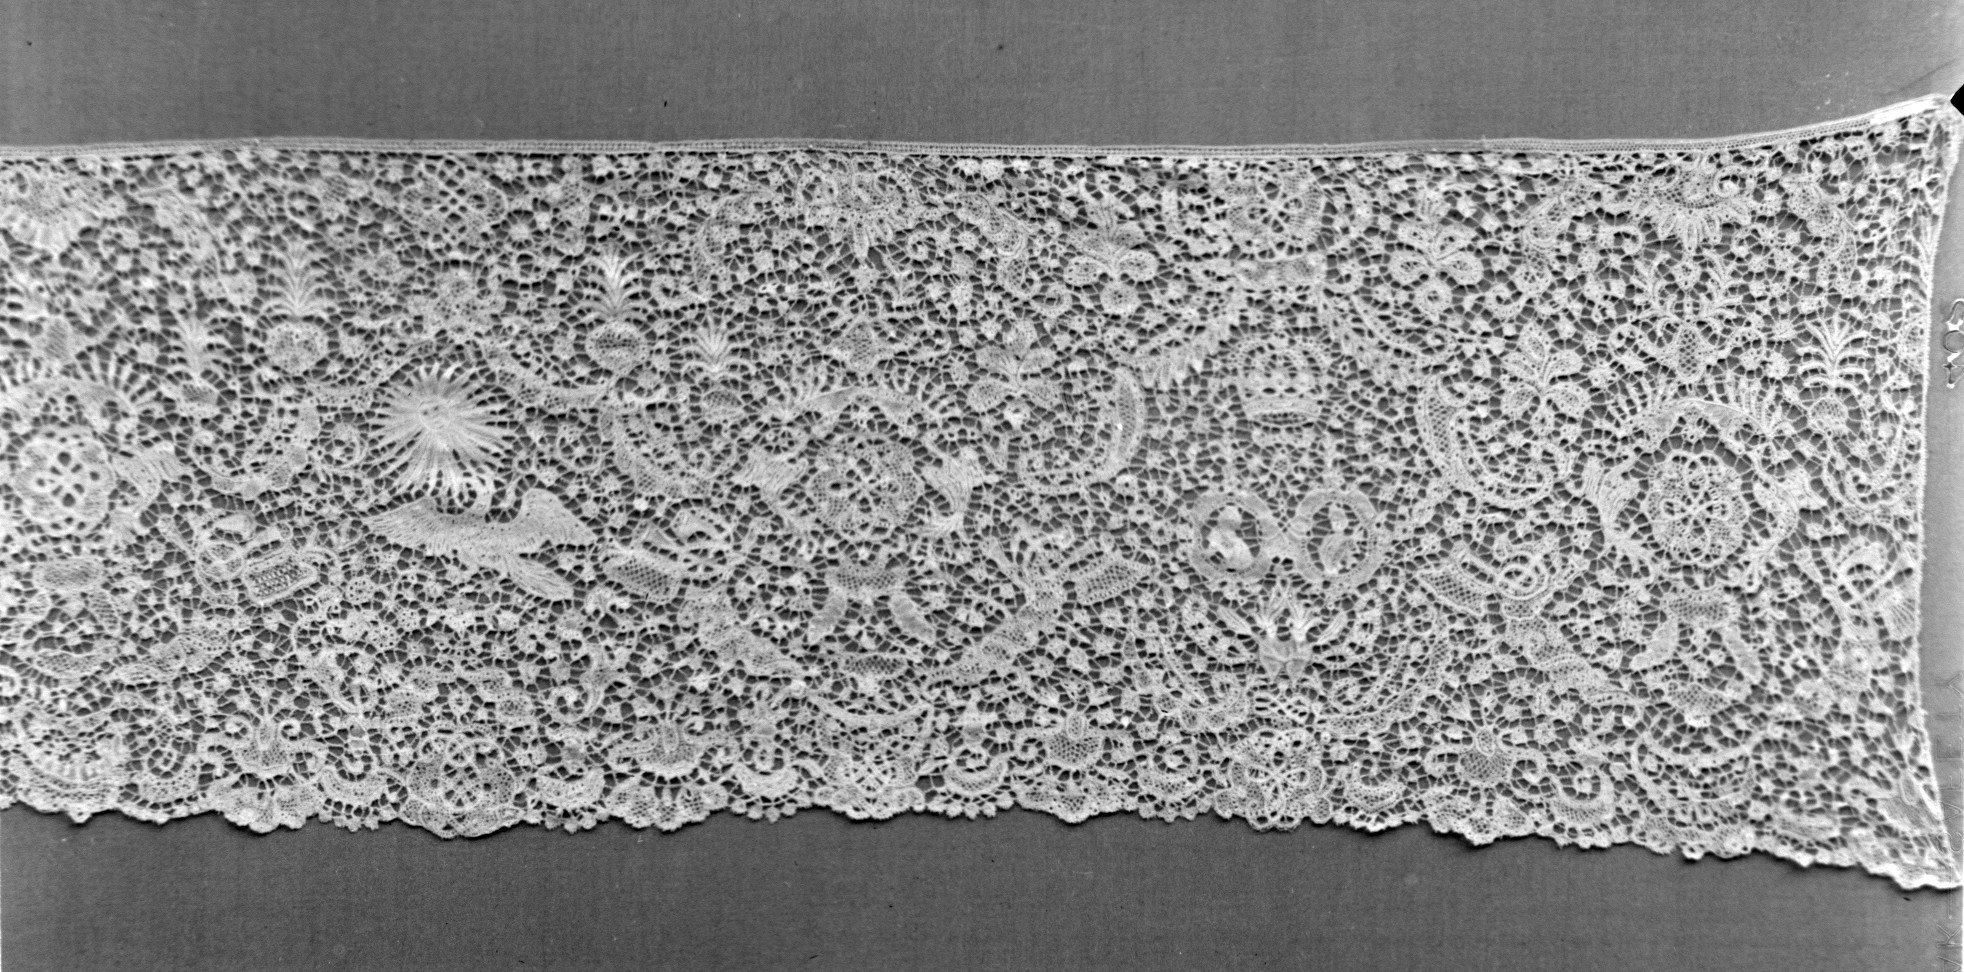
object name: flounce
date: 1701-1733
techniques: lace